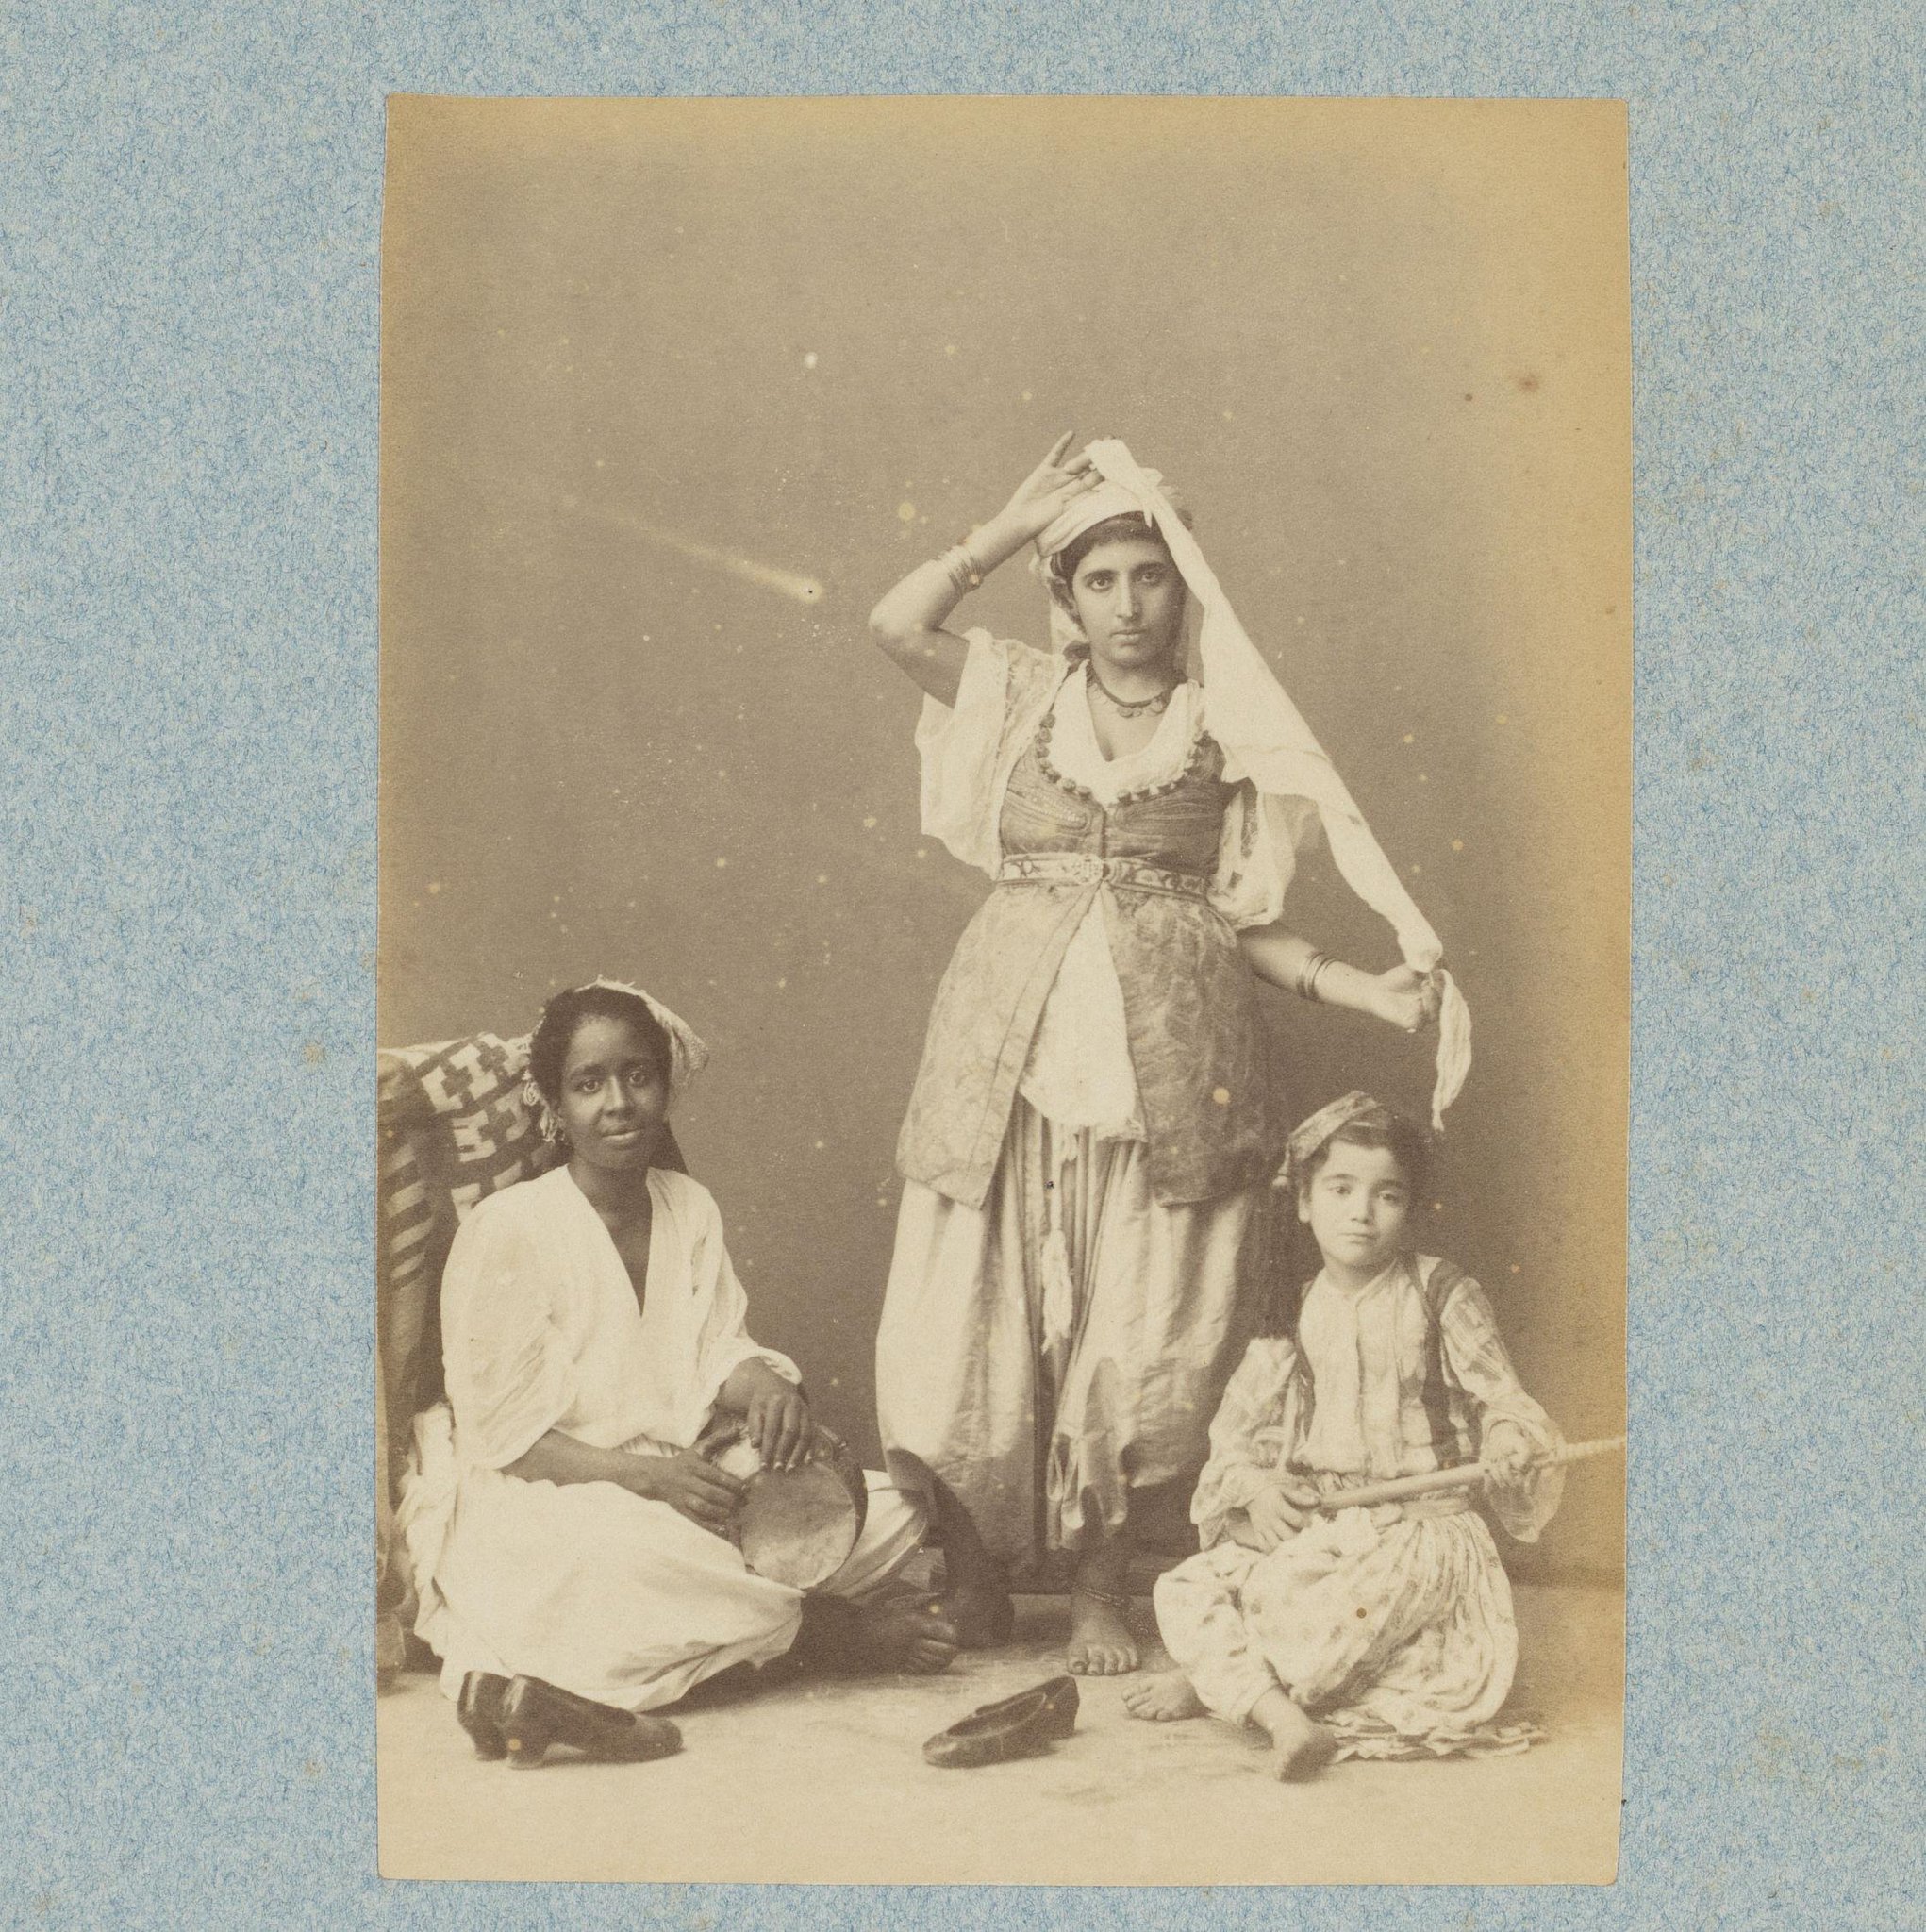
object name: photograph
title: Portret van twee onbekende Algerijnse vrouwen en een meisje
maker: Anonymous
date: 1851-1900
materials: cardboard, paper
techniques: albumen print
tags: girl (child between toddler and youth), anonymous historical person portrayed - bb - woman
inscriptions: inscription: ‘l'Alger’, inscription: ‘[...]’, collector's mark: ‘VOSMAER’